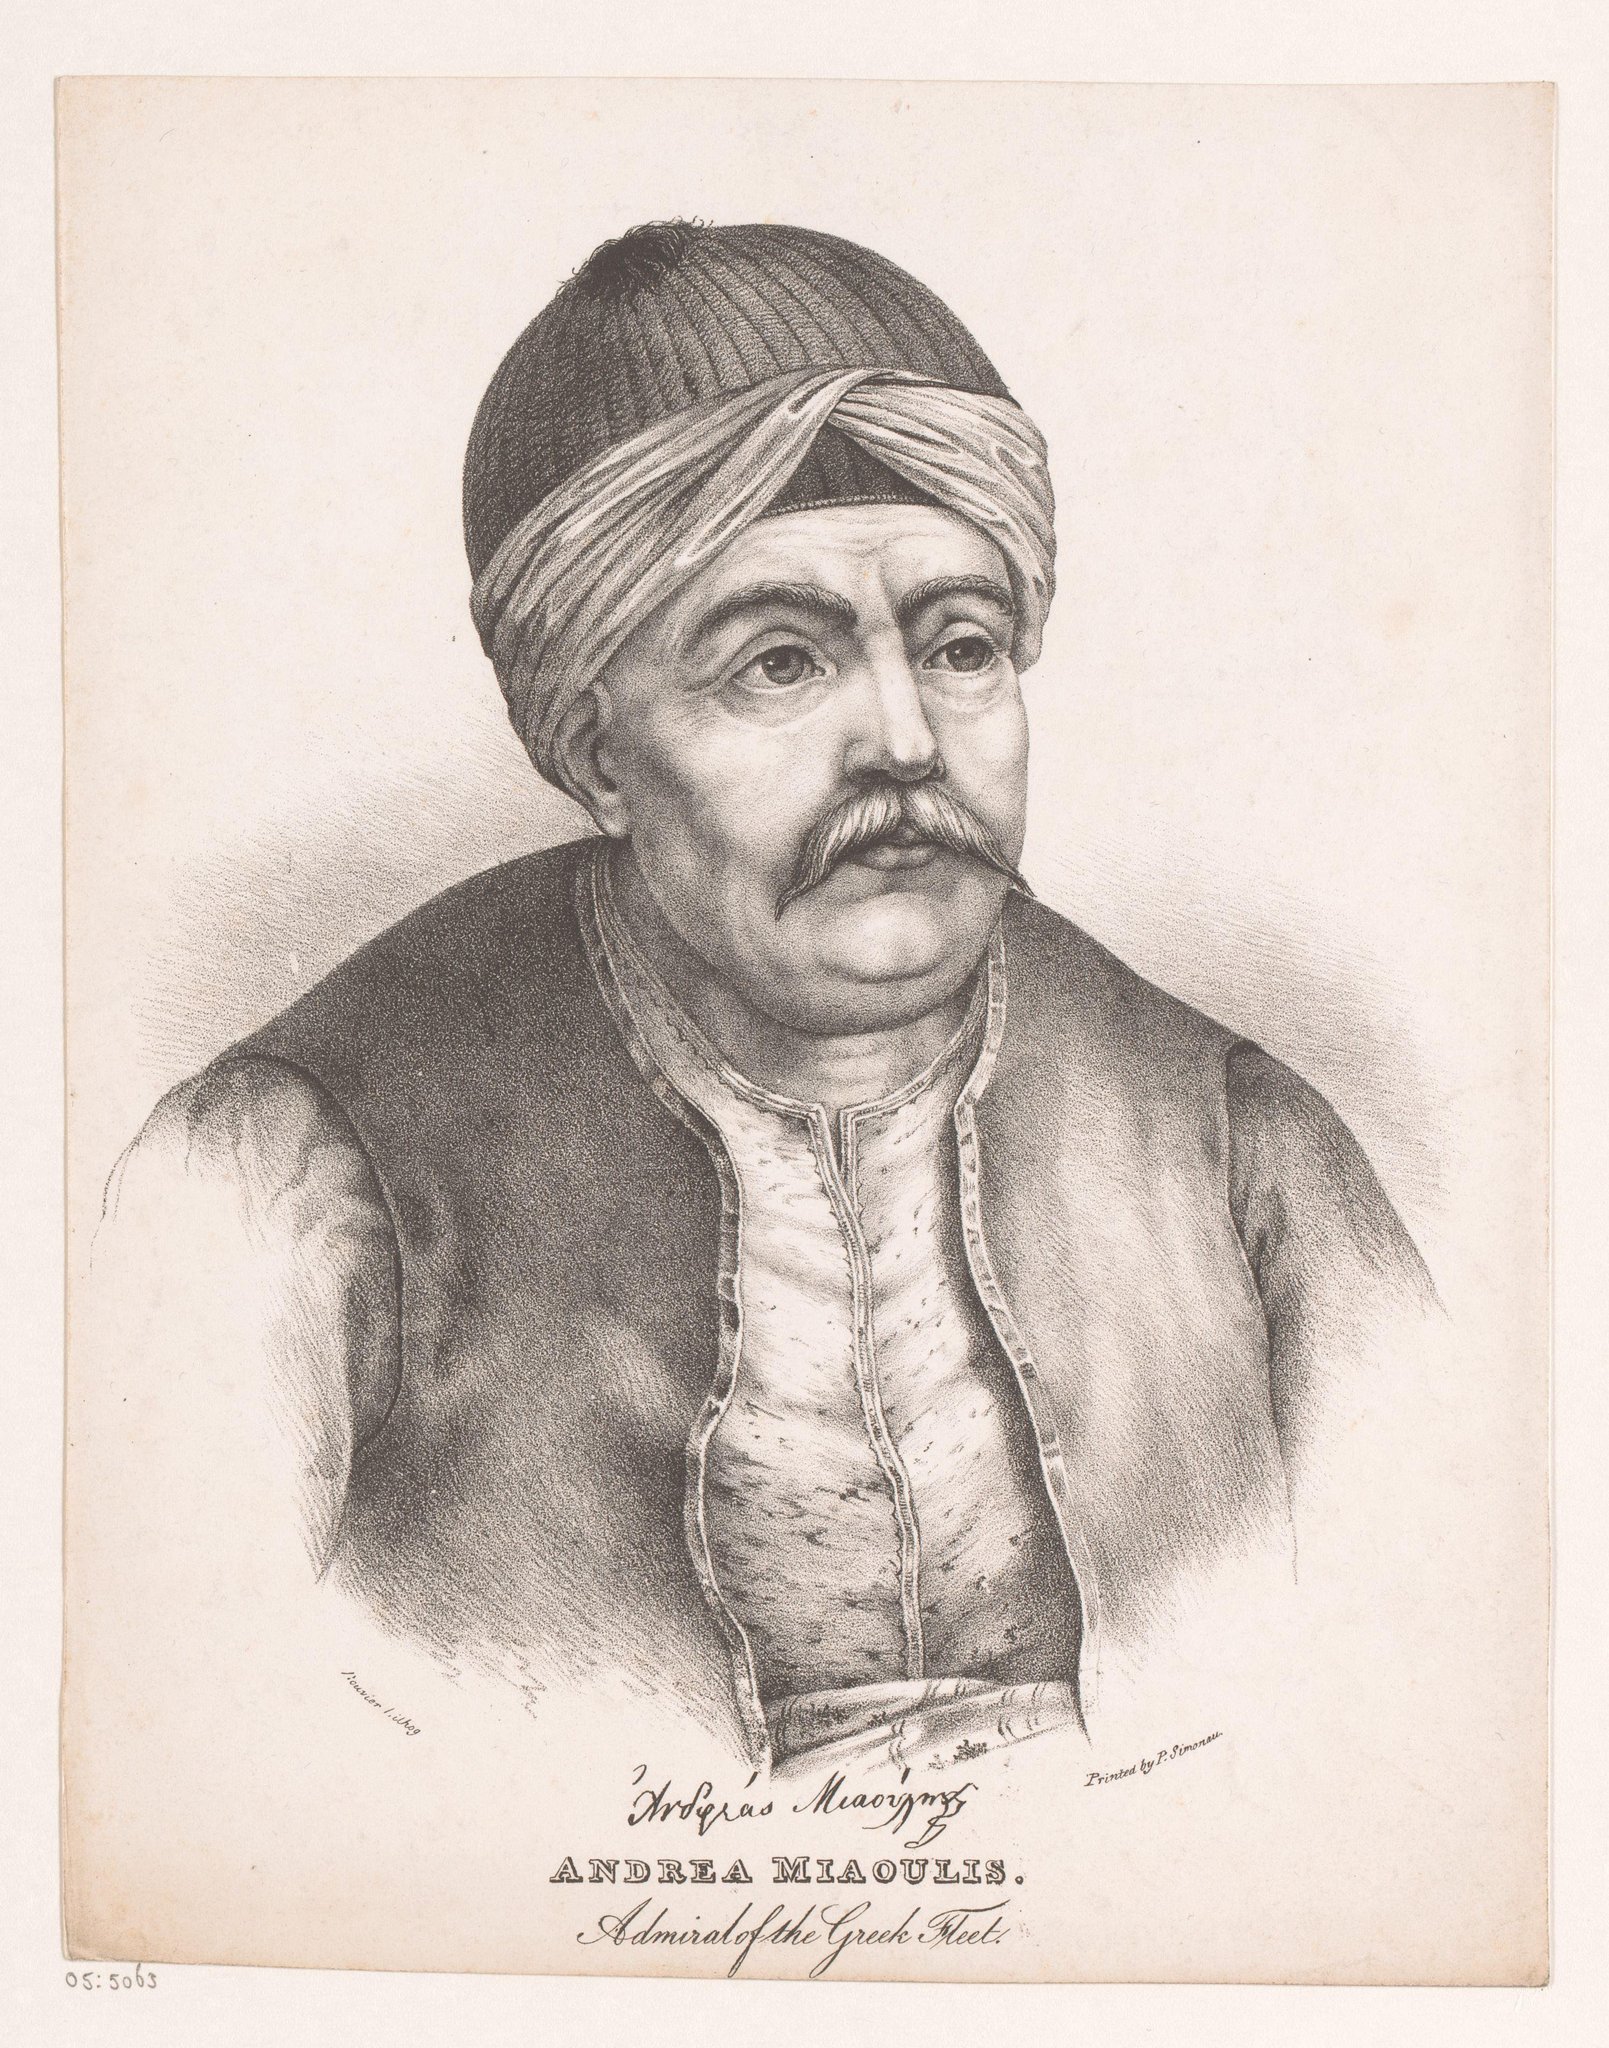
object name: print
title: Andrea Miaoulis. Admiral of the Greek Fleet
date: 1826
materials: paper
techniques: lithograph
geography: london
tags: moustache, adult man, historical persons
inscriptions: collector's mark: Lugt 2228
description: Prent behoort mogelijk tot een serie portretten van figuren betrokken bij de Griekse onafhankelijkheidsoorlog.